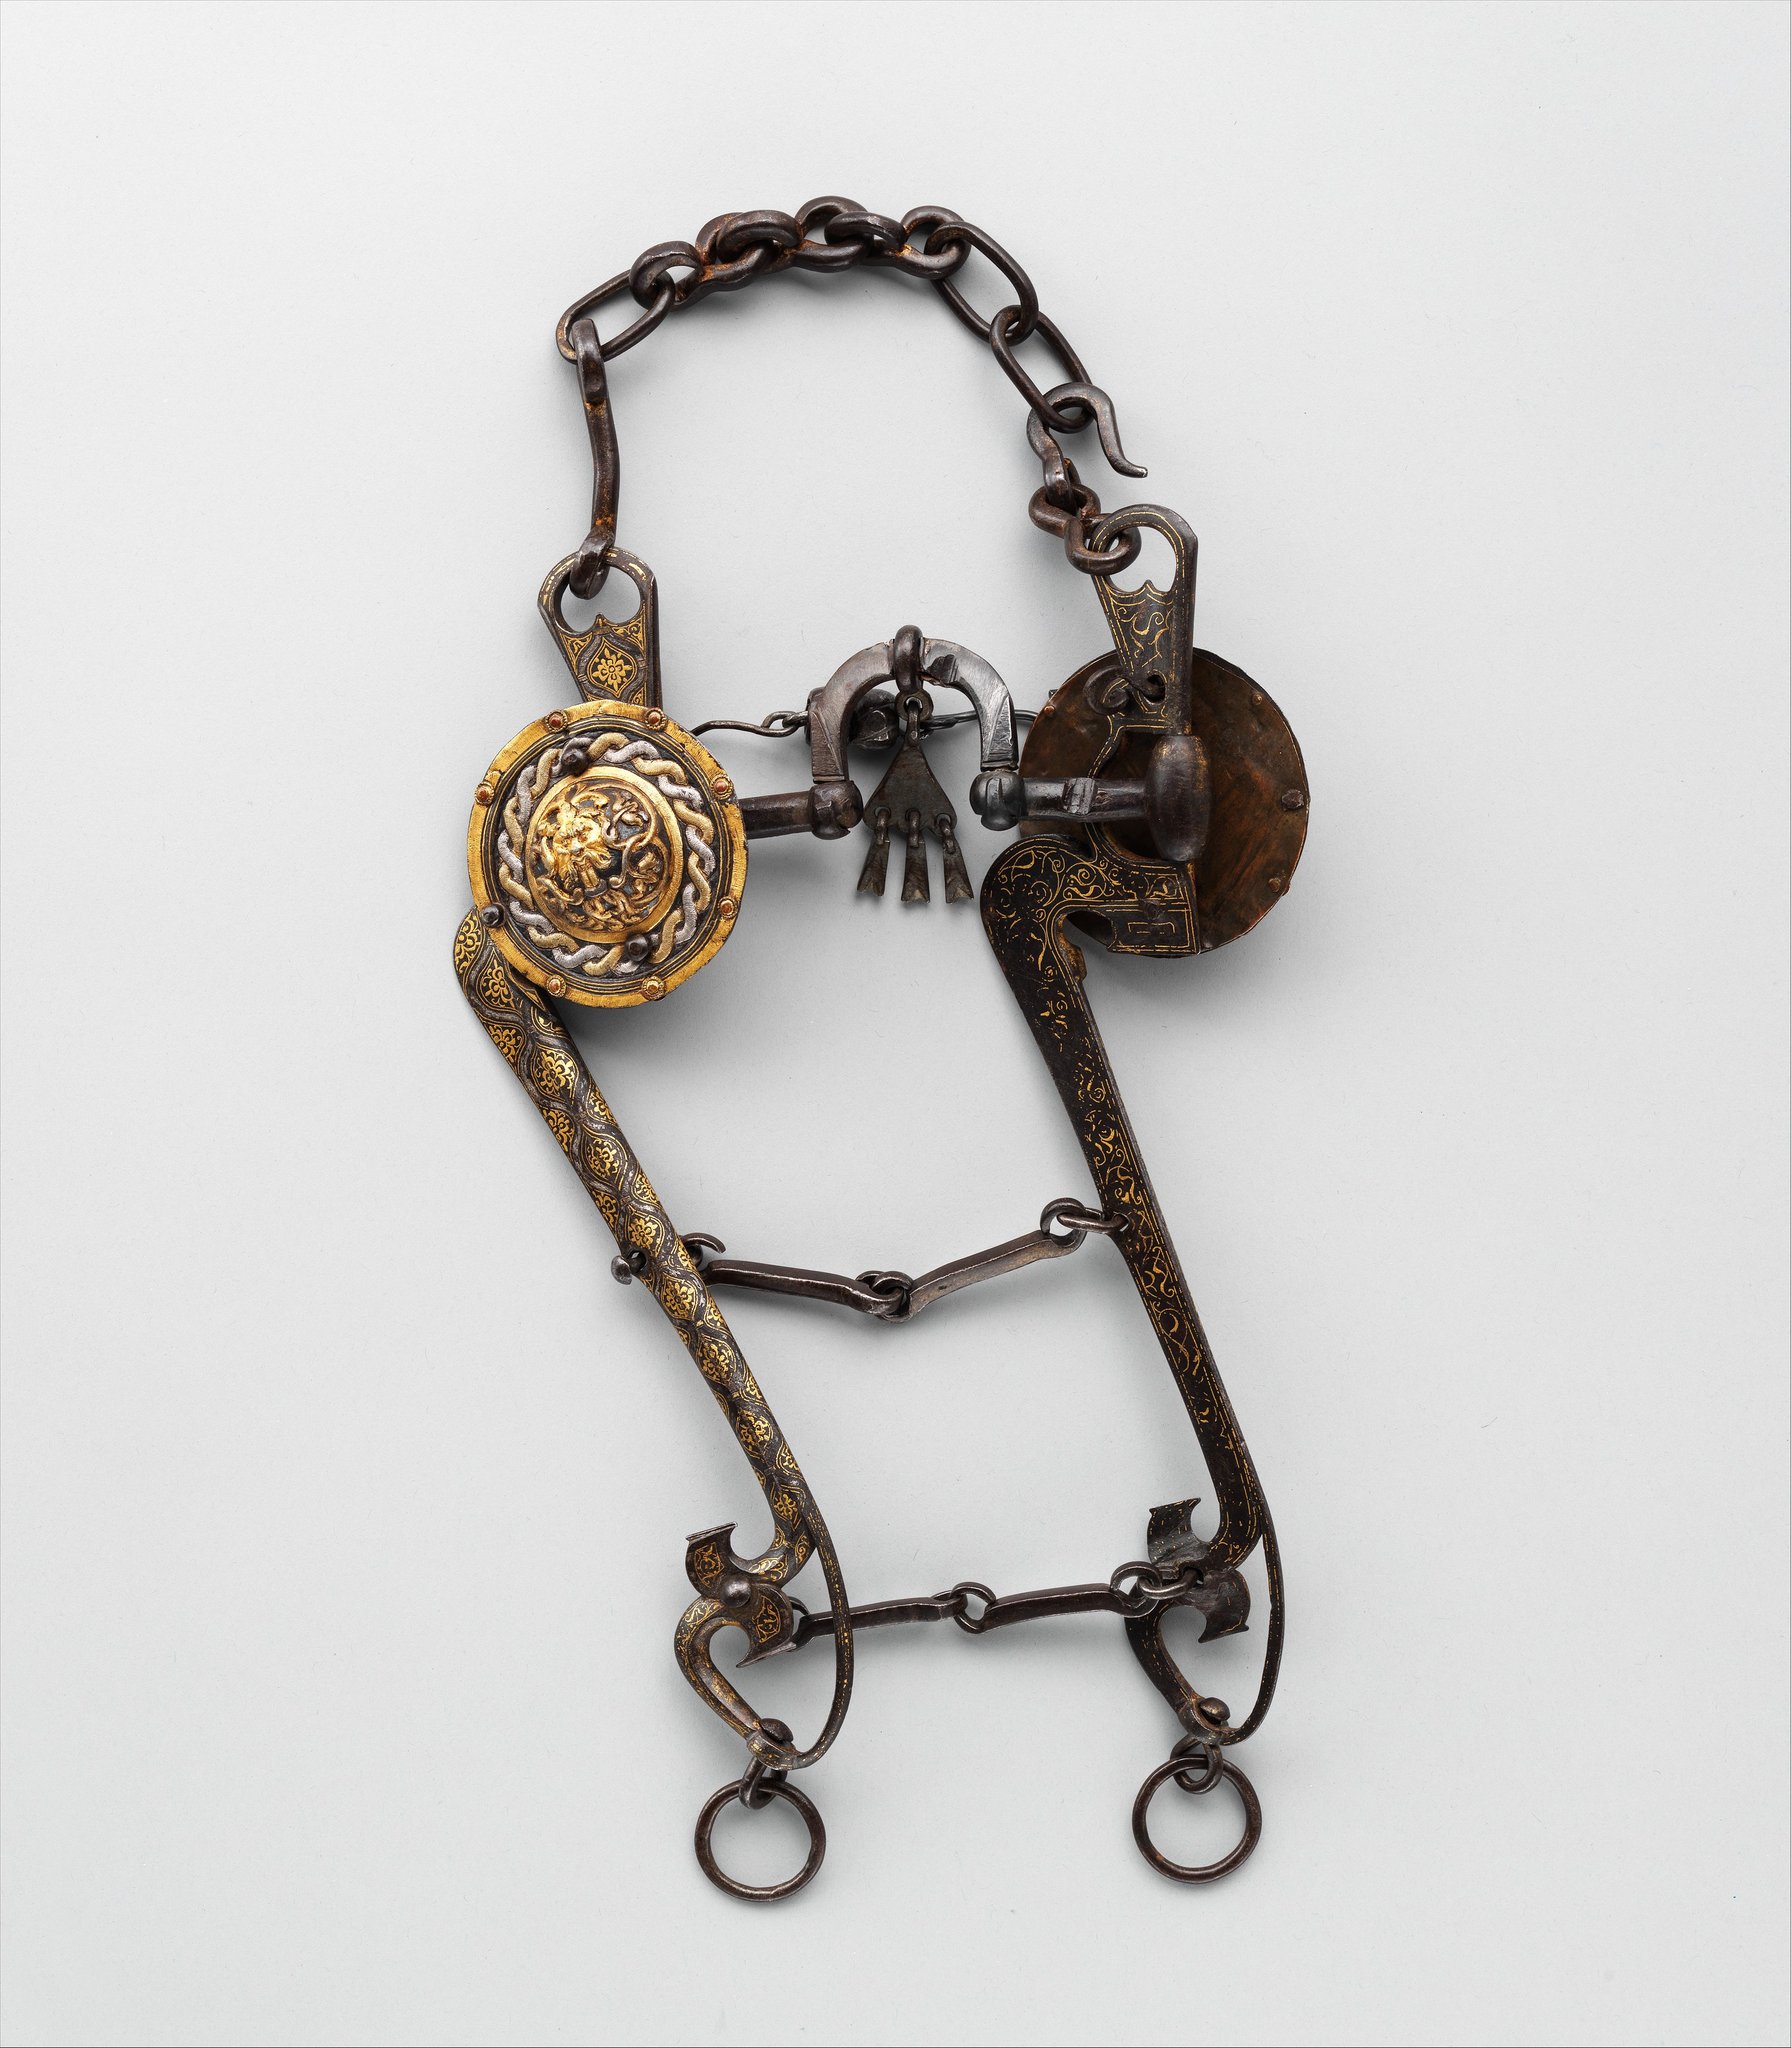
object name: bit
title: Curb Bit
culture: italian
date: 1550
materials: copper alloy, gold, iron, silver, tin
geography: italy